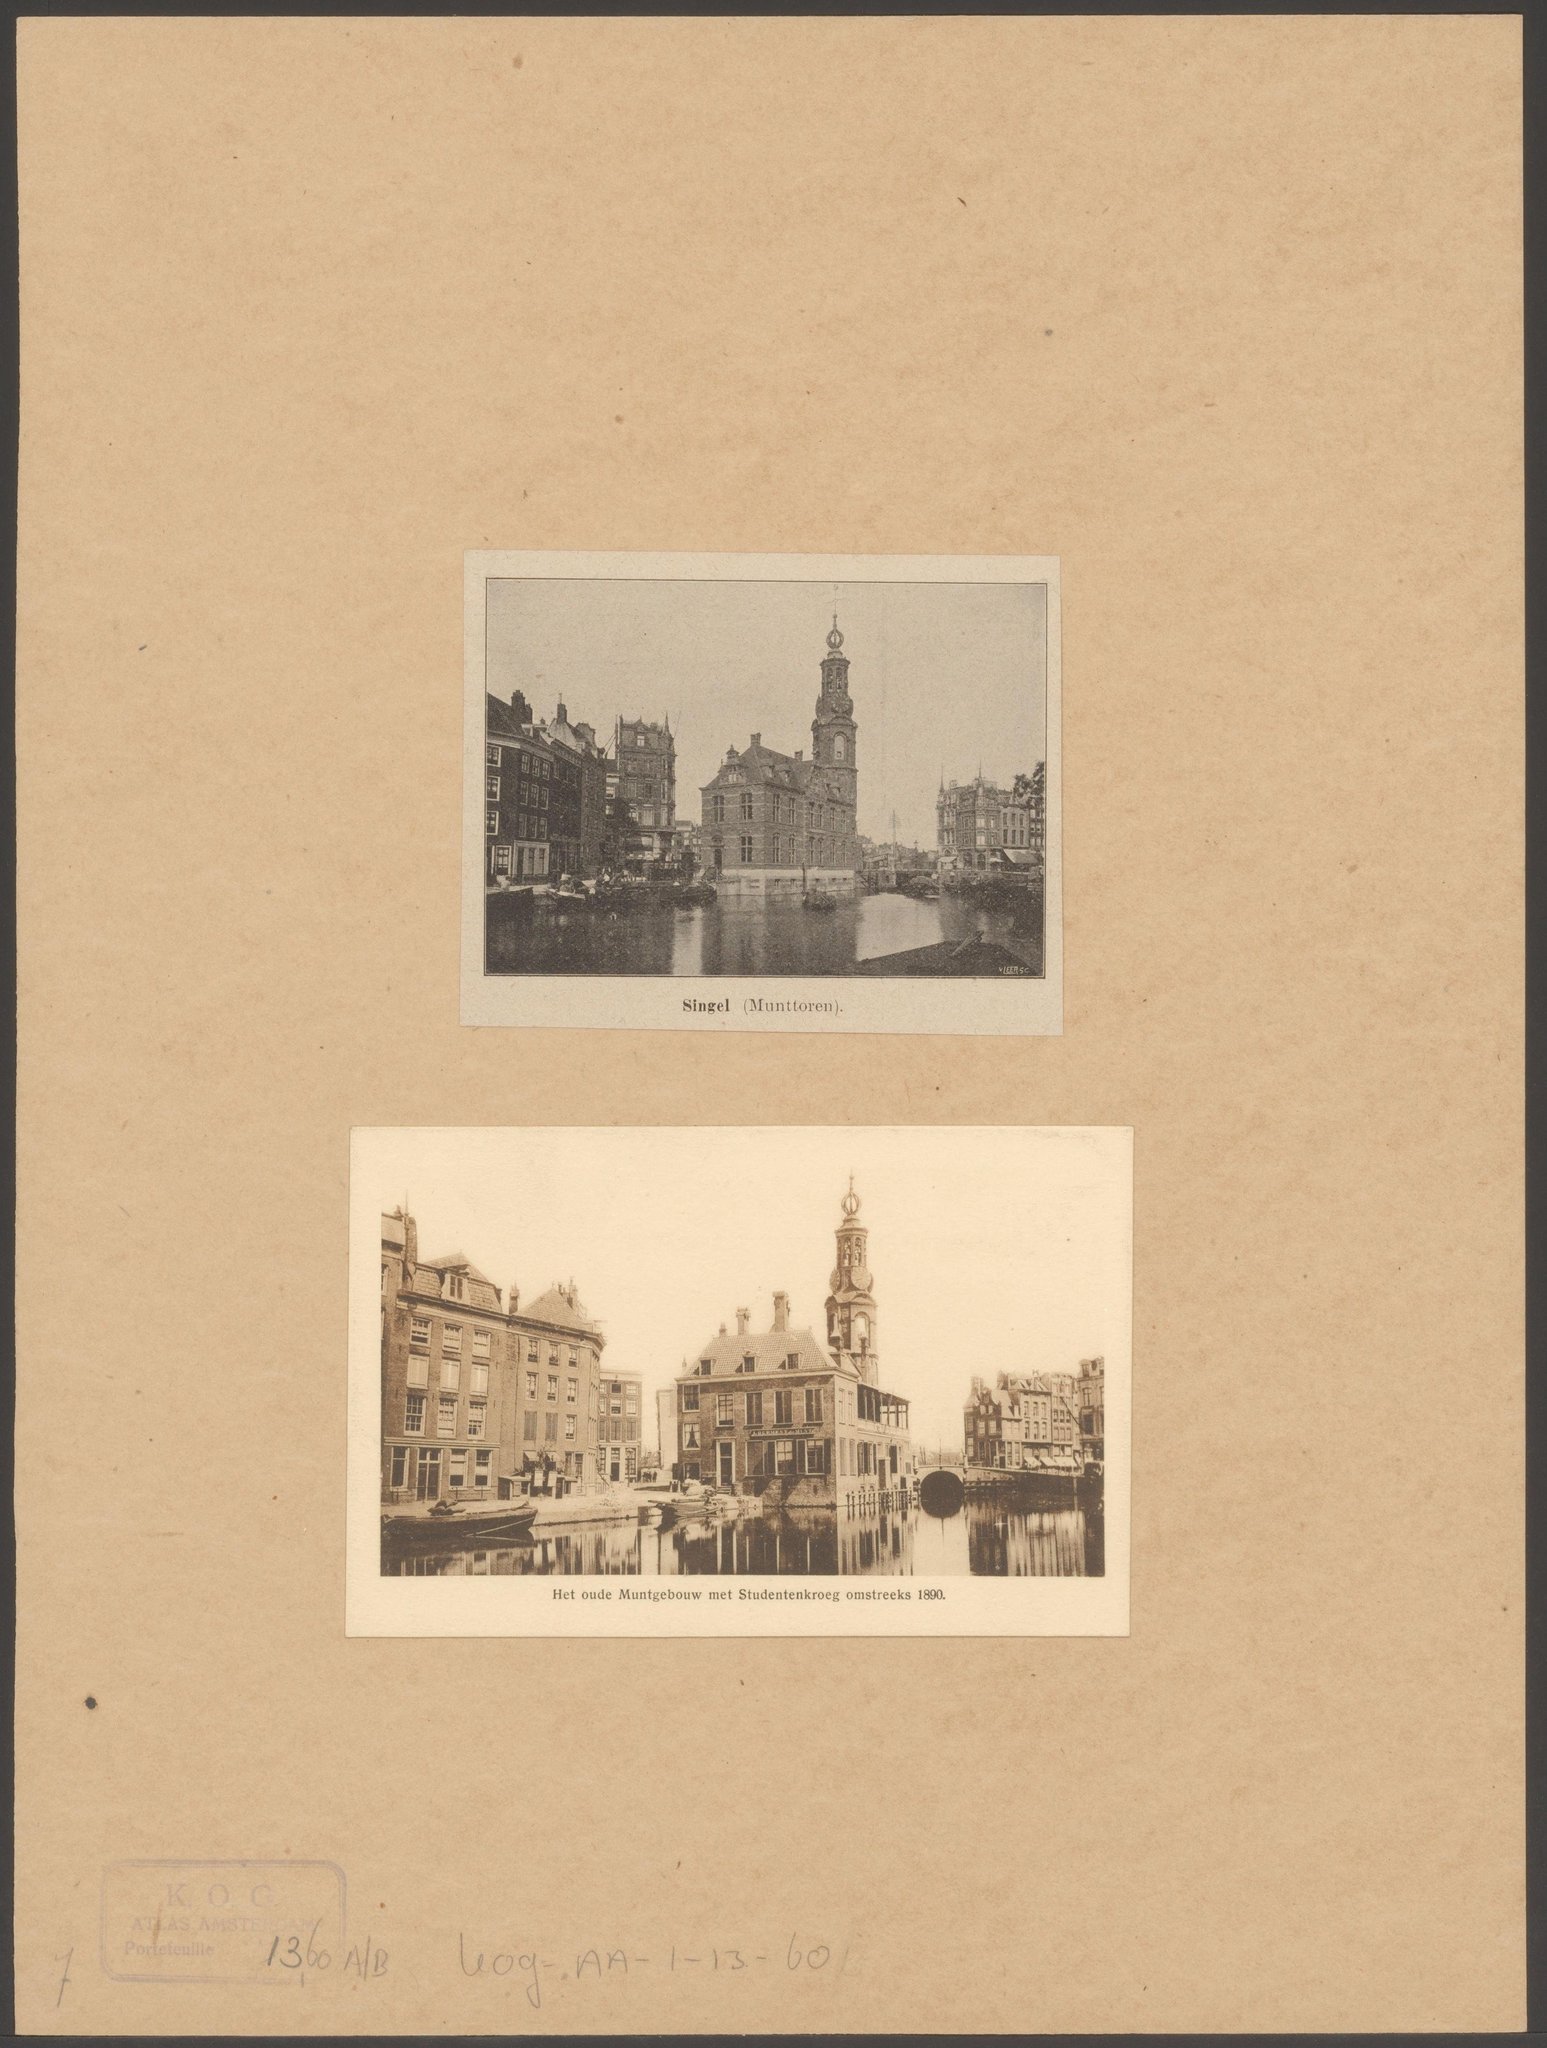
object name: ansichtkaart, prentbriefkaart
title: Gezicht op de Munttoren vanaf het Singel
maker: Anonymous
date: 1882-1950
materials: cardboard, paper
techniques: photograph, letterpress printing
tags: tower, clock tower ~ monumental adornment, city-view in general; 'veduta', canal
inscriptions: collector's mark: ‘13,60A/B’ Lugt 1641b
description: Onderwerpsrubriek binnen de Atlas Amsterdam: Oude Schans, Schoutensteeg, Singel (Korte), Singel.